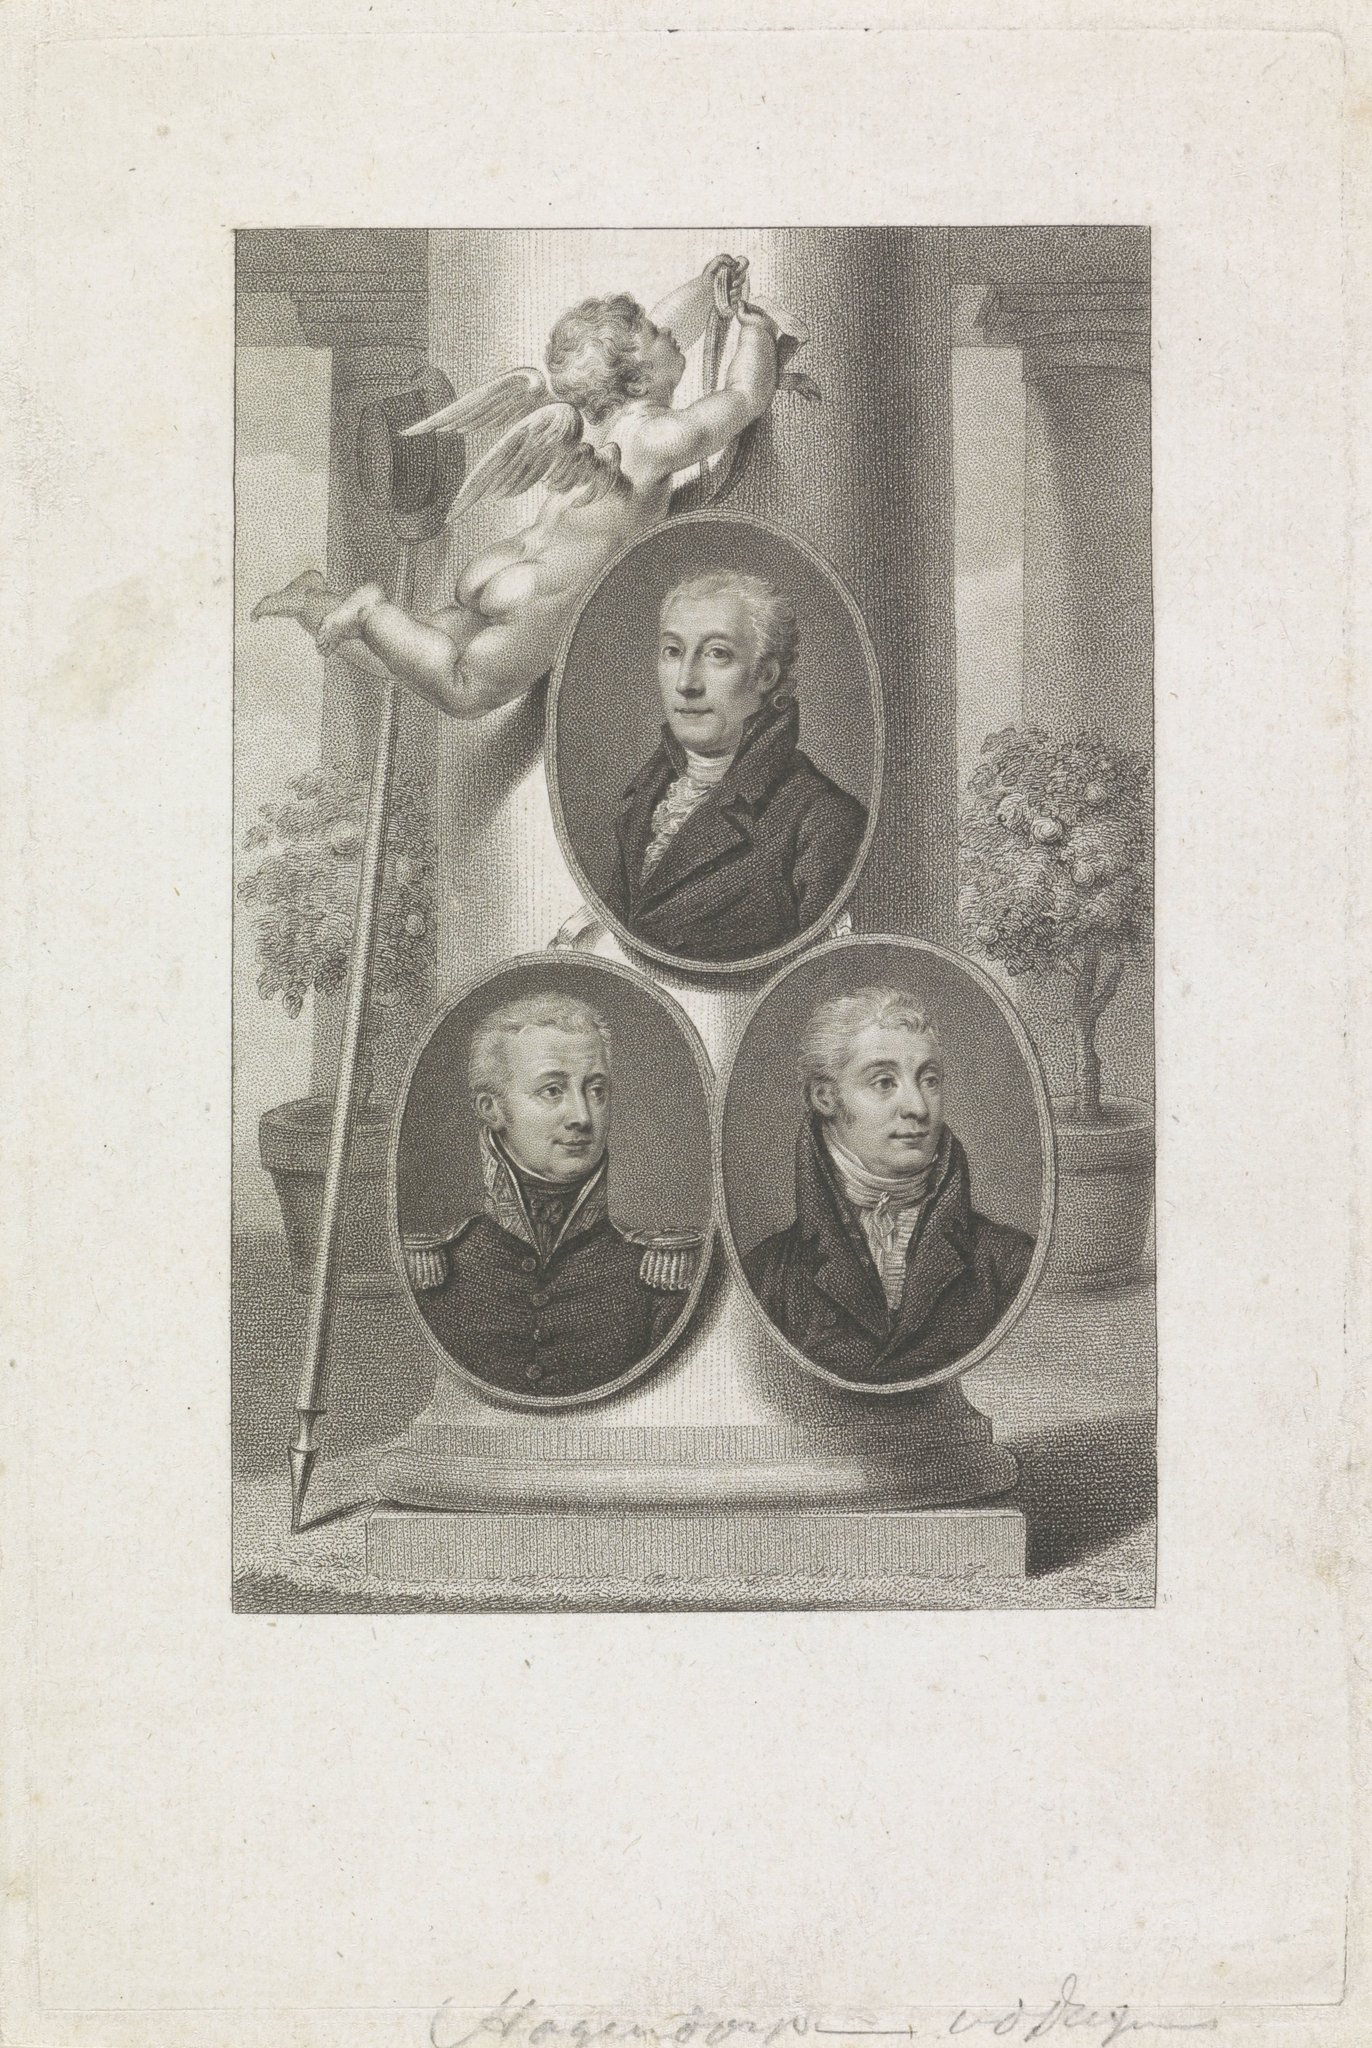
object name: print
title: Driemanschap van 1813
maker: Anonymous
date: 1813-1815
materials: paper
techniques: engraving, etching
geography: netherlands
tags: berlin, william i of the netherlands, rotterdam, gijsbert karel graaf van hogendorp, deventer, adam françois jules armand van der duyn, landing of william frederick i (1813)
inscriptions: collector's mark: Lugt 2228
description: Een putto hangt de portretten van de leden van het Driemanschap van 1813 aan een zuil: Van Hogendorp, Van Limburg Stirum en Van der Duyn van Maasdam. Op de achtergrond twee potten met oranjebomen.